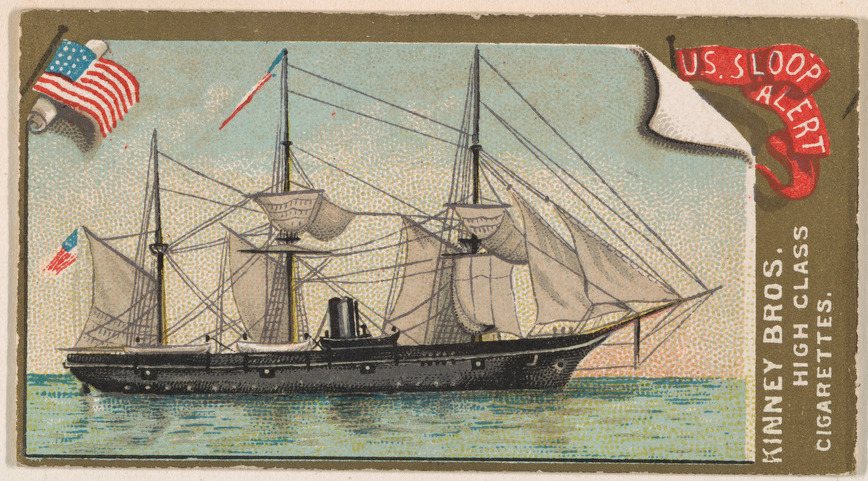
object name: print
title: U.S. Sloop Alert, from the Naval Vessels of the World series (N226) issued by Kinney Bros.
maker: kinney brothers tobacco company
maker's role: publisher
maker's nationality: american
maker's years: 1869-2011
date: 1889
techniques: color lithograph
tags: navy,ships